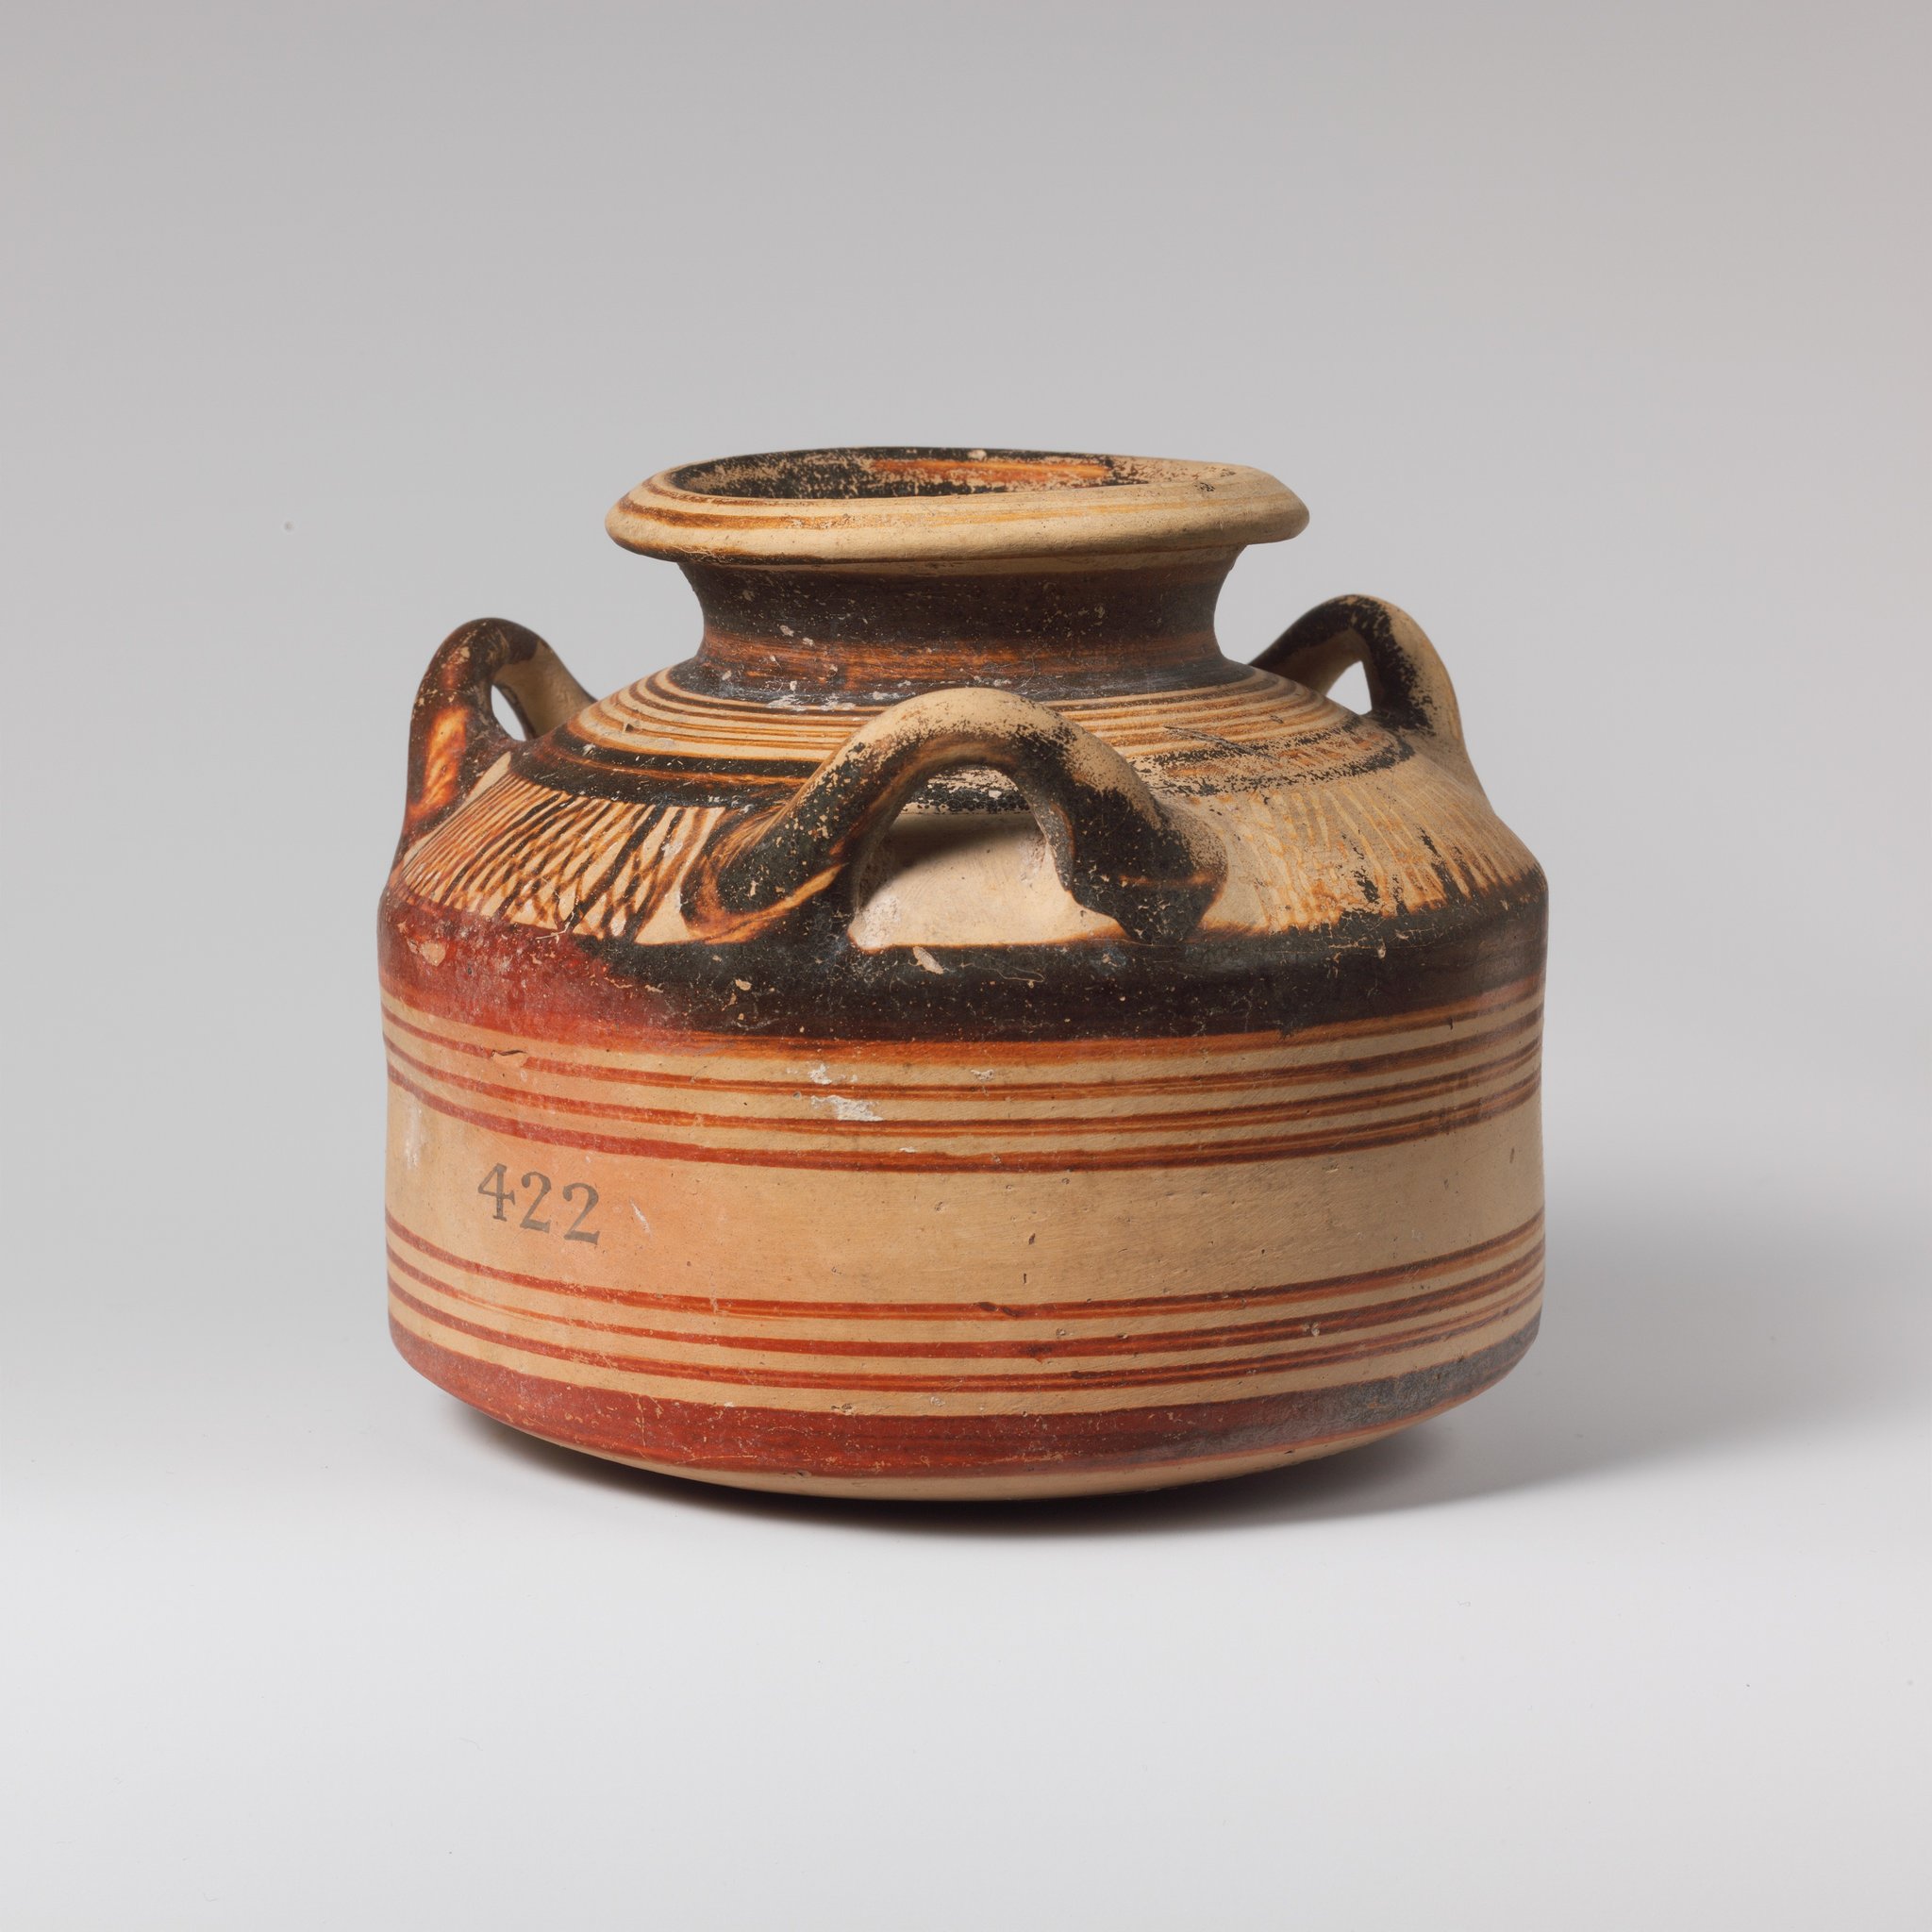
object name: pyxis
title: Terracotta alabastron (jar)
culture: mycenaean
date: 1600-1050 BCE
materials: terracotta